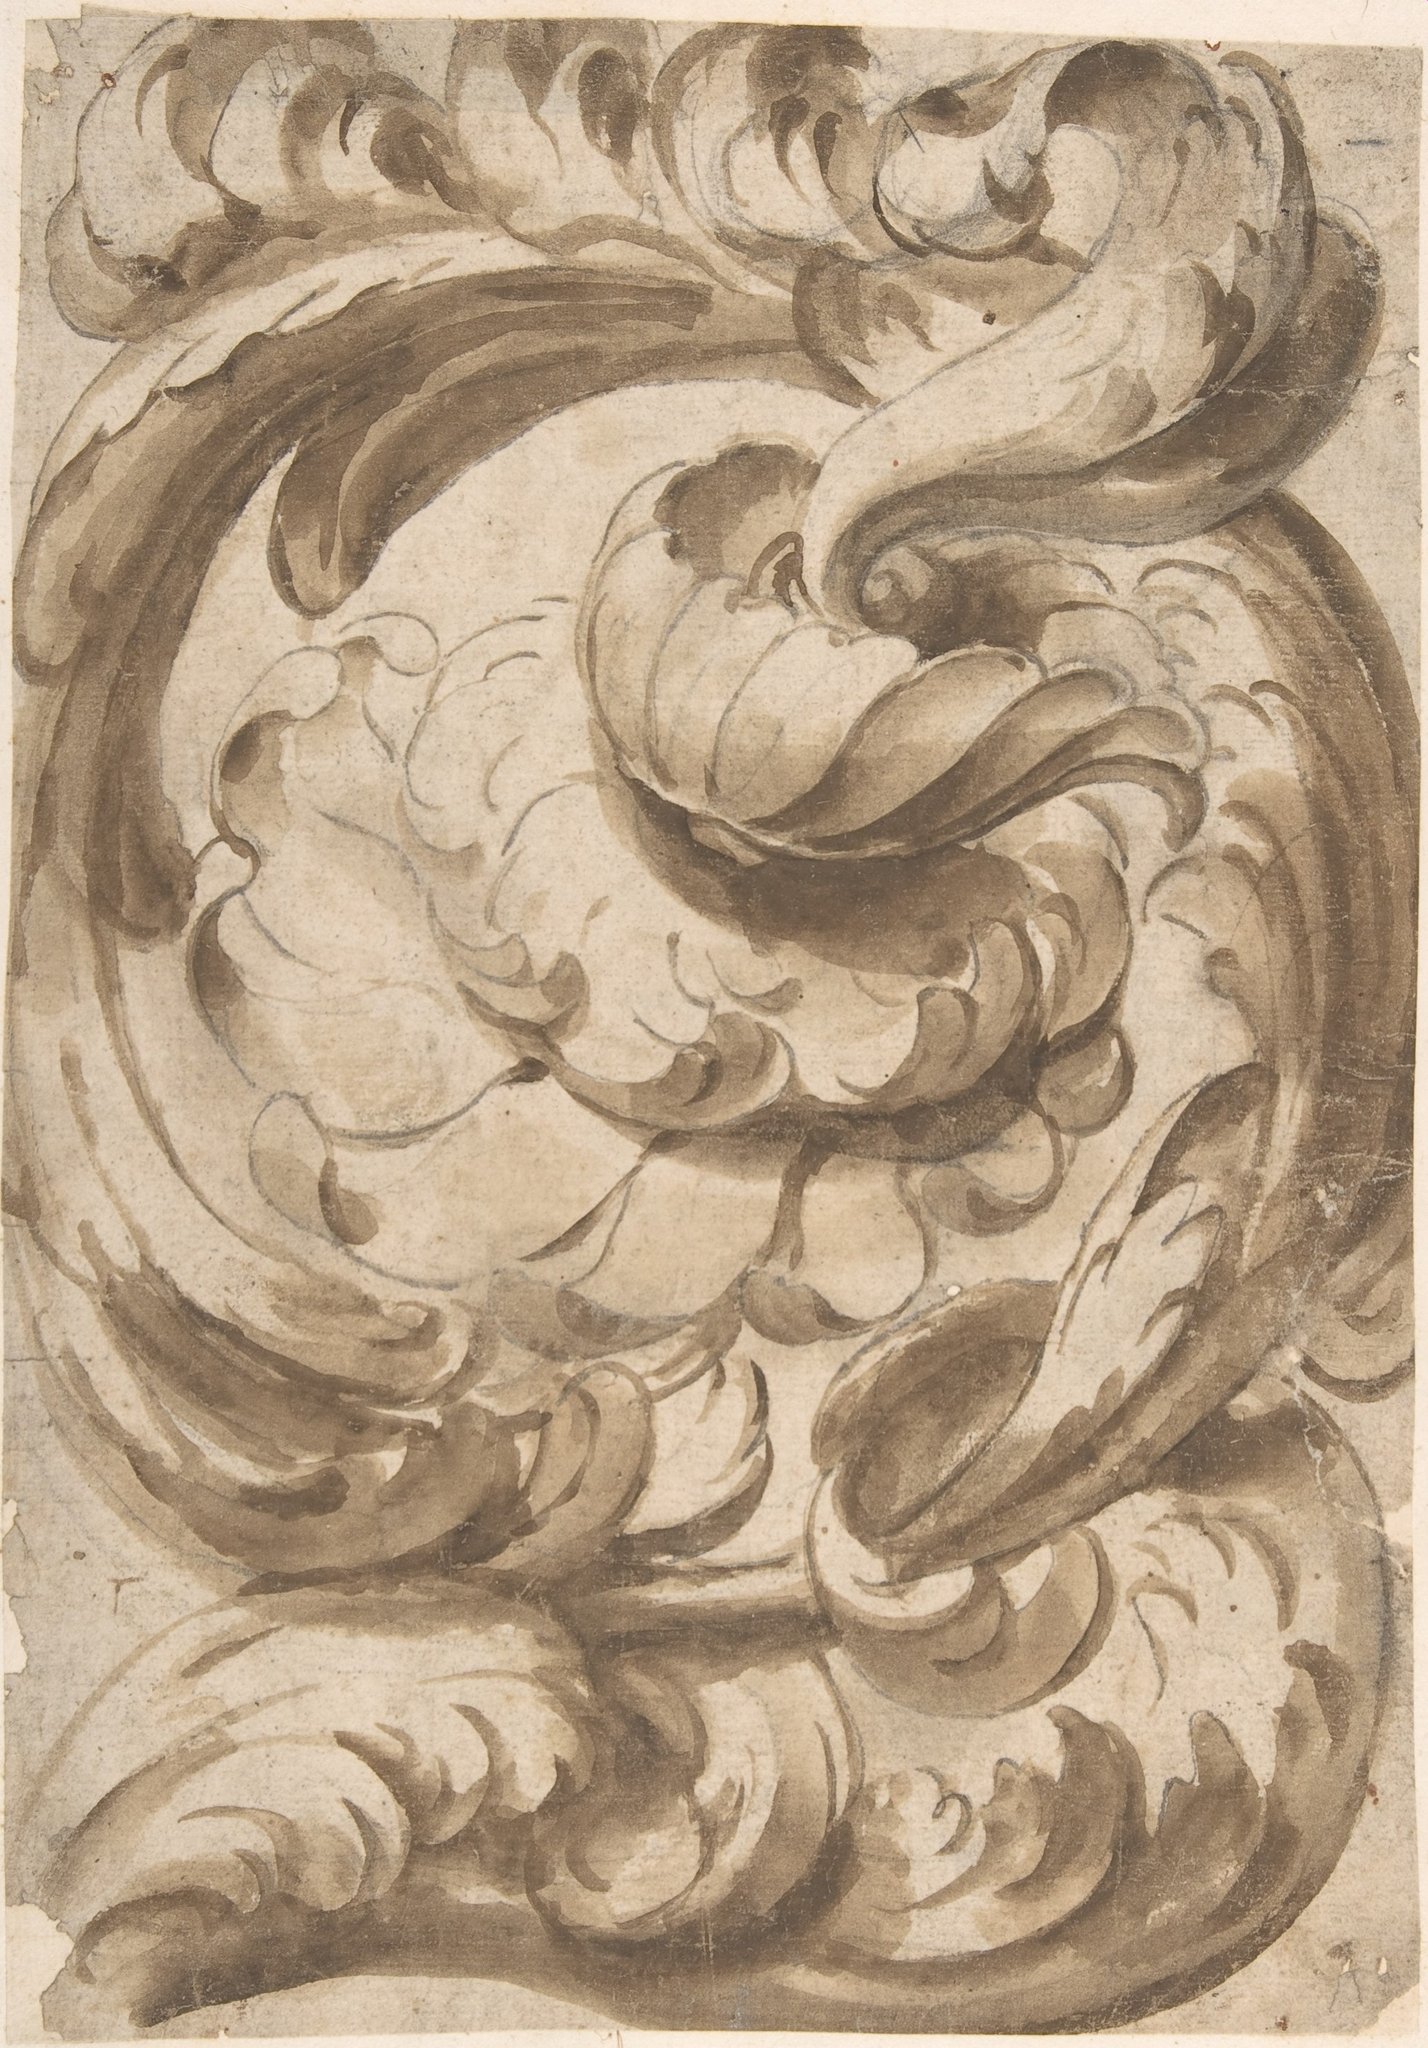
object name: drawing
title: Acanthus Scroll with Rosette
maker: anonymous, italian, 17th century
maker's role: artist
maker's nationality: italian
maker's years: 1600-1700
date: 1601-1700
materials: graphite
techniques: brush, wash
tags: acanthus